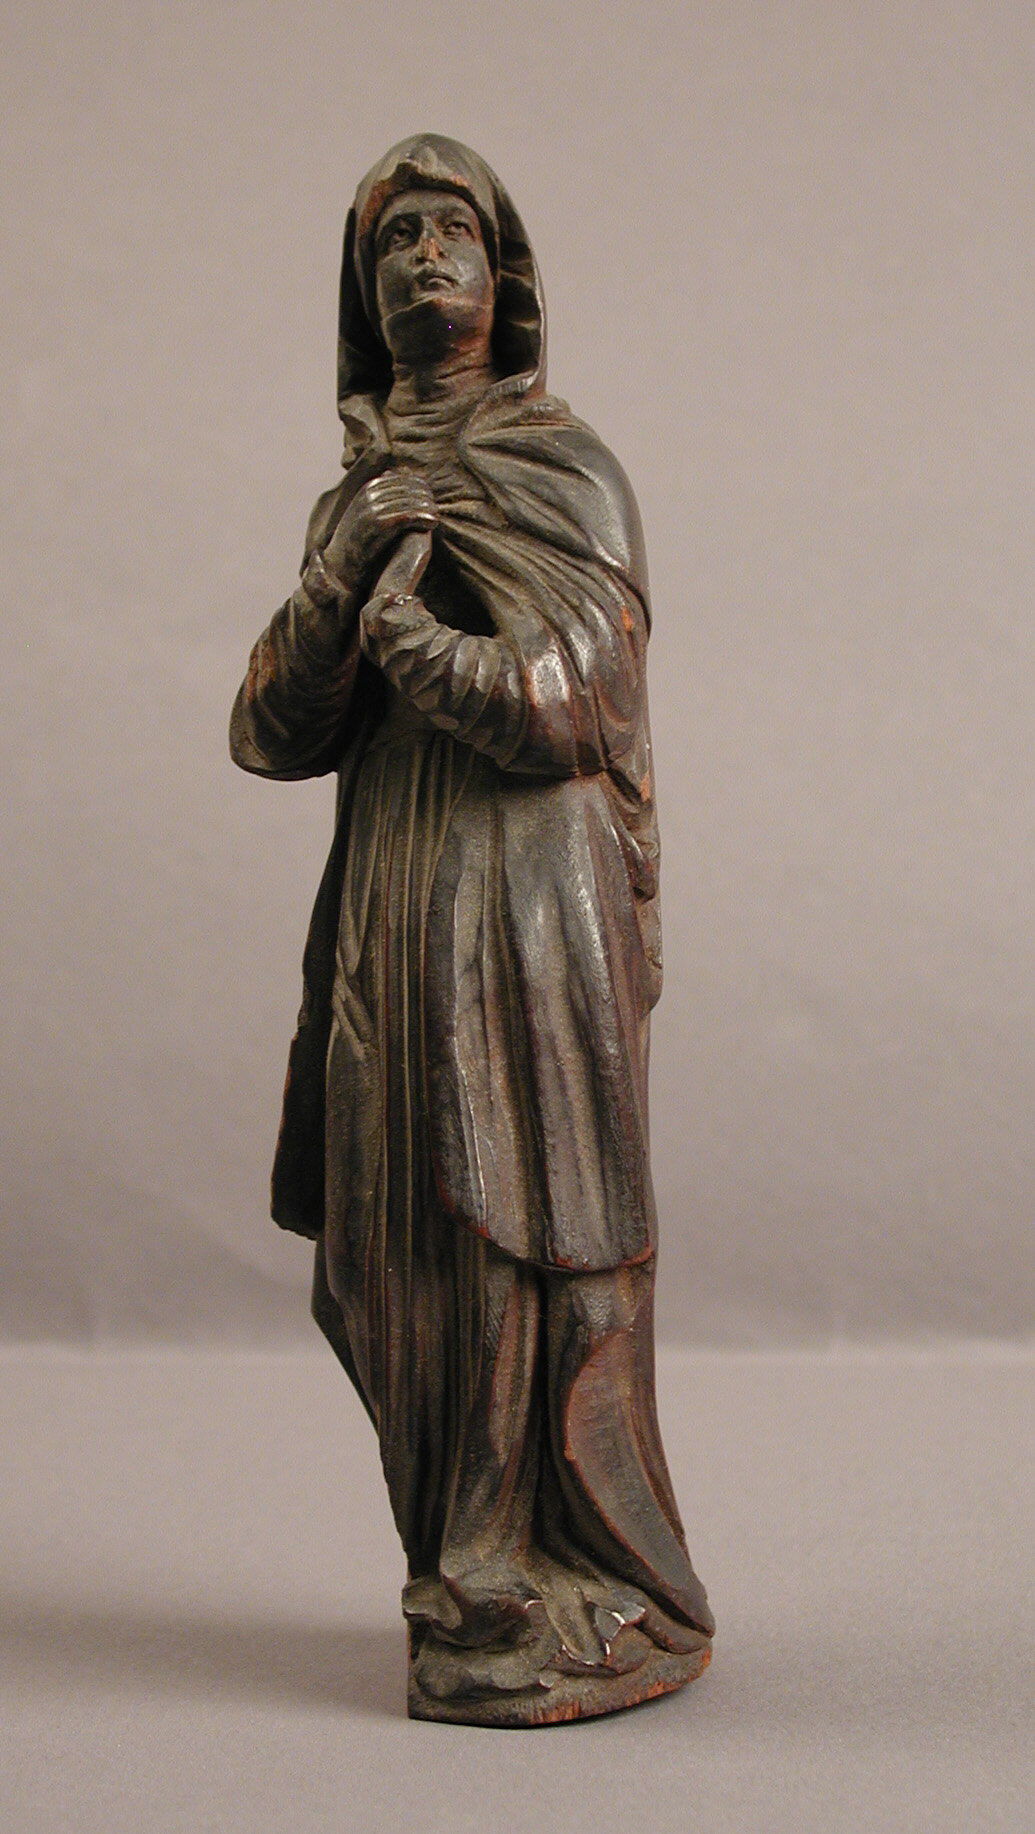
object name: statuette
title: Saint Clare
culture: german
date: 1501-1600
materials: wood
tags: saints